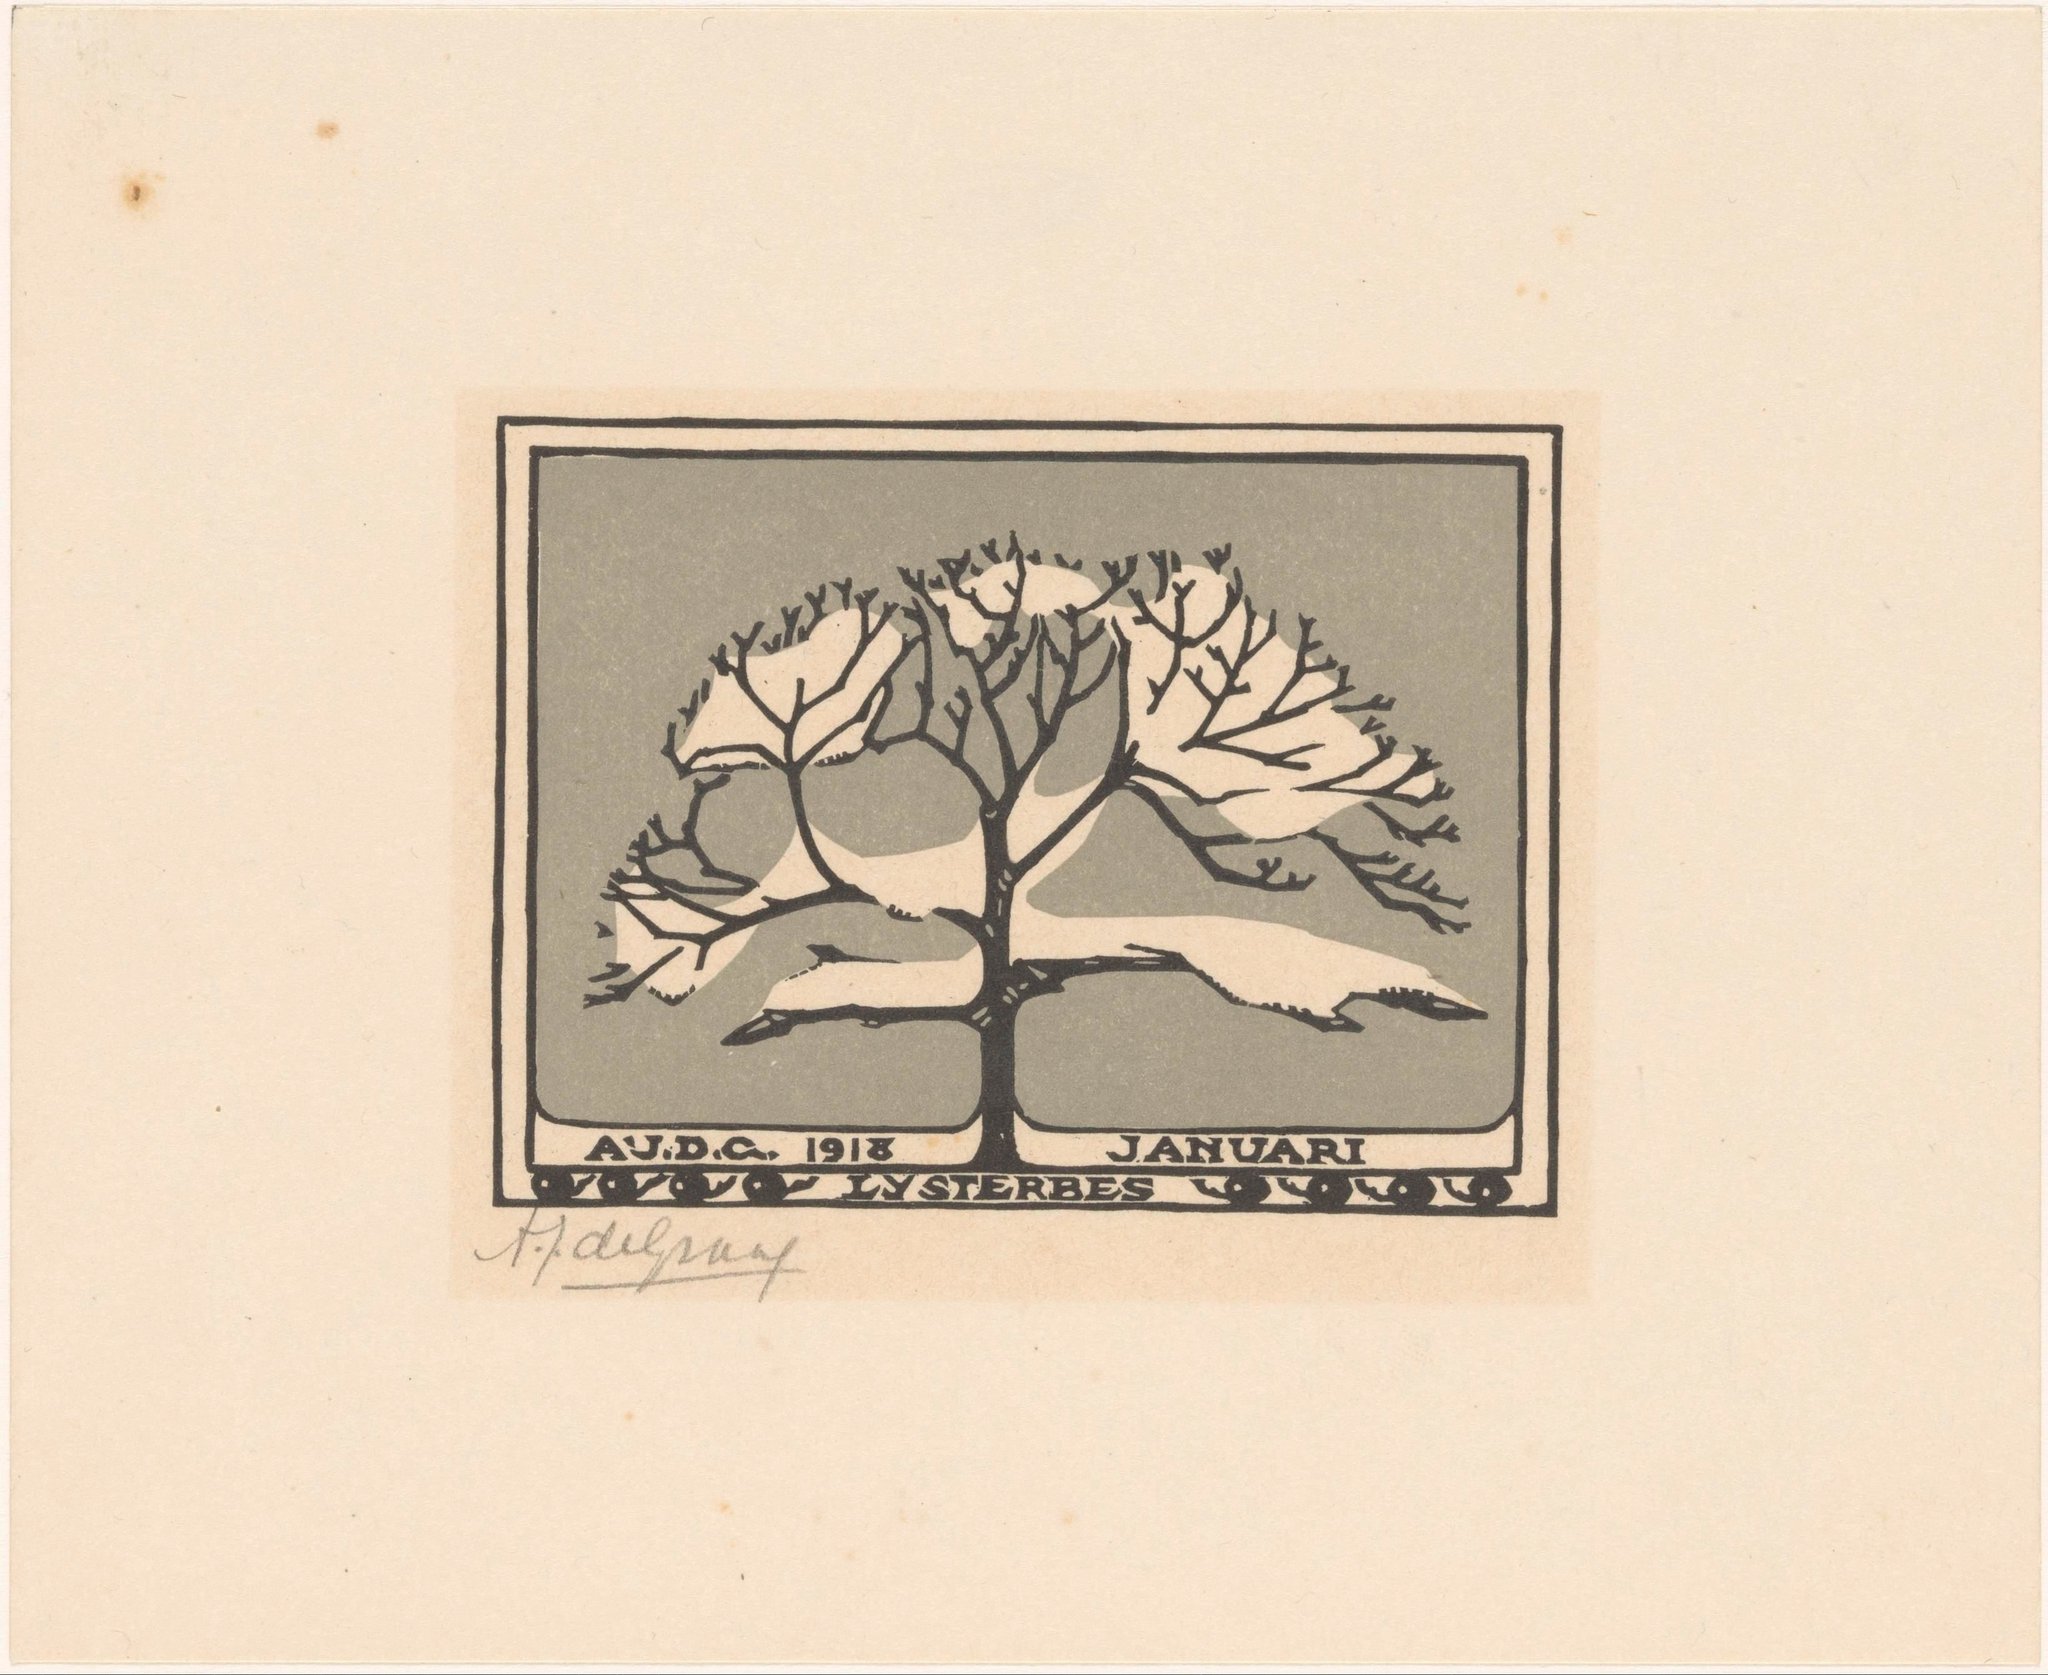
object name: print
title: Januari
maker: julie de graag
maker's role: draughtsman, print maker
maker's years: 1877-1924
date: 1918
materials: paper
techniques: woodcut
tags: trees (+ bare plant), january; 'gennaro' (ripa)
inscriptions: collector's mark: Lugt 2228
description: Een lijsterbes (Sorbus) met kale takken bedekt met sneeuw.